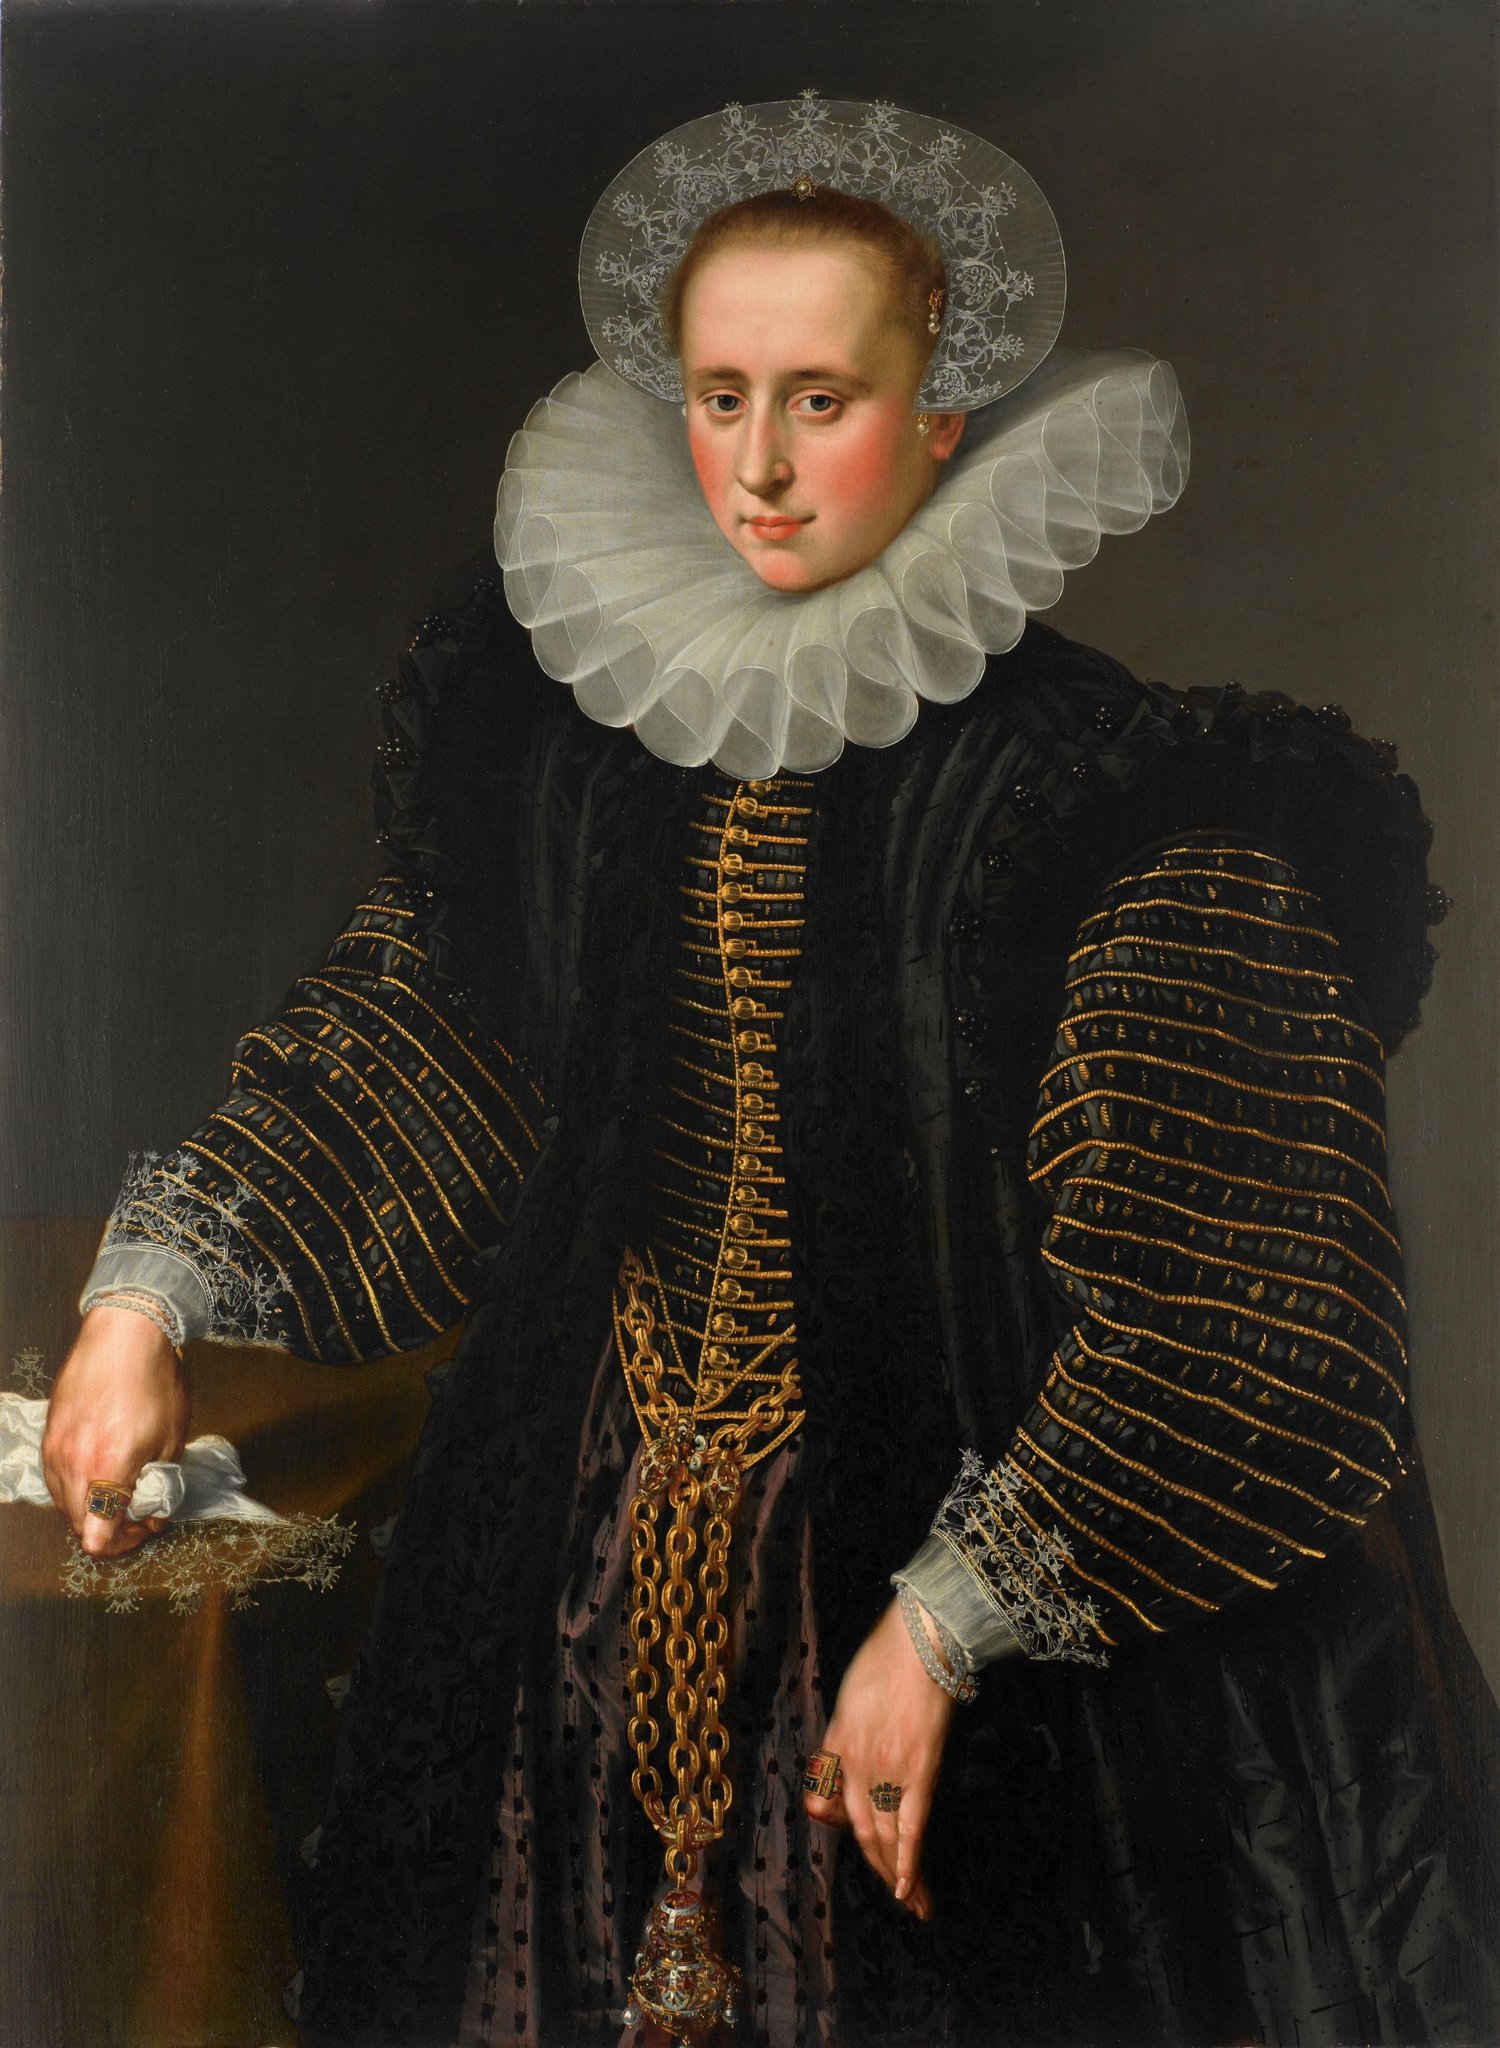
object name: painting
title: Portrait of a Woman, probably Maria Schuurman (1575-1621)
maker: Anonymous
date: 1599-1600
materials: oil, panel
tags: amsterdam, historical persons - bb - woman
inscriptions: label, on the reverse: ‘Anna Maria Schuurmans’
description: Portret van een jonge aanzienlijke vrouw, waarschijnlijk Maria Schuurman (1575-1621). Kniestuk, staande bij een tafeltje waarop de rechterhand met zakdoek rust. Om de middel een ketting met een hanger.